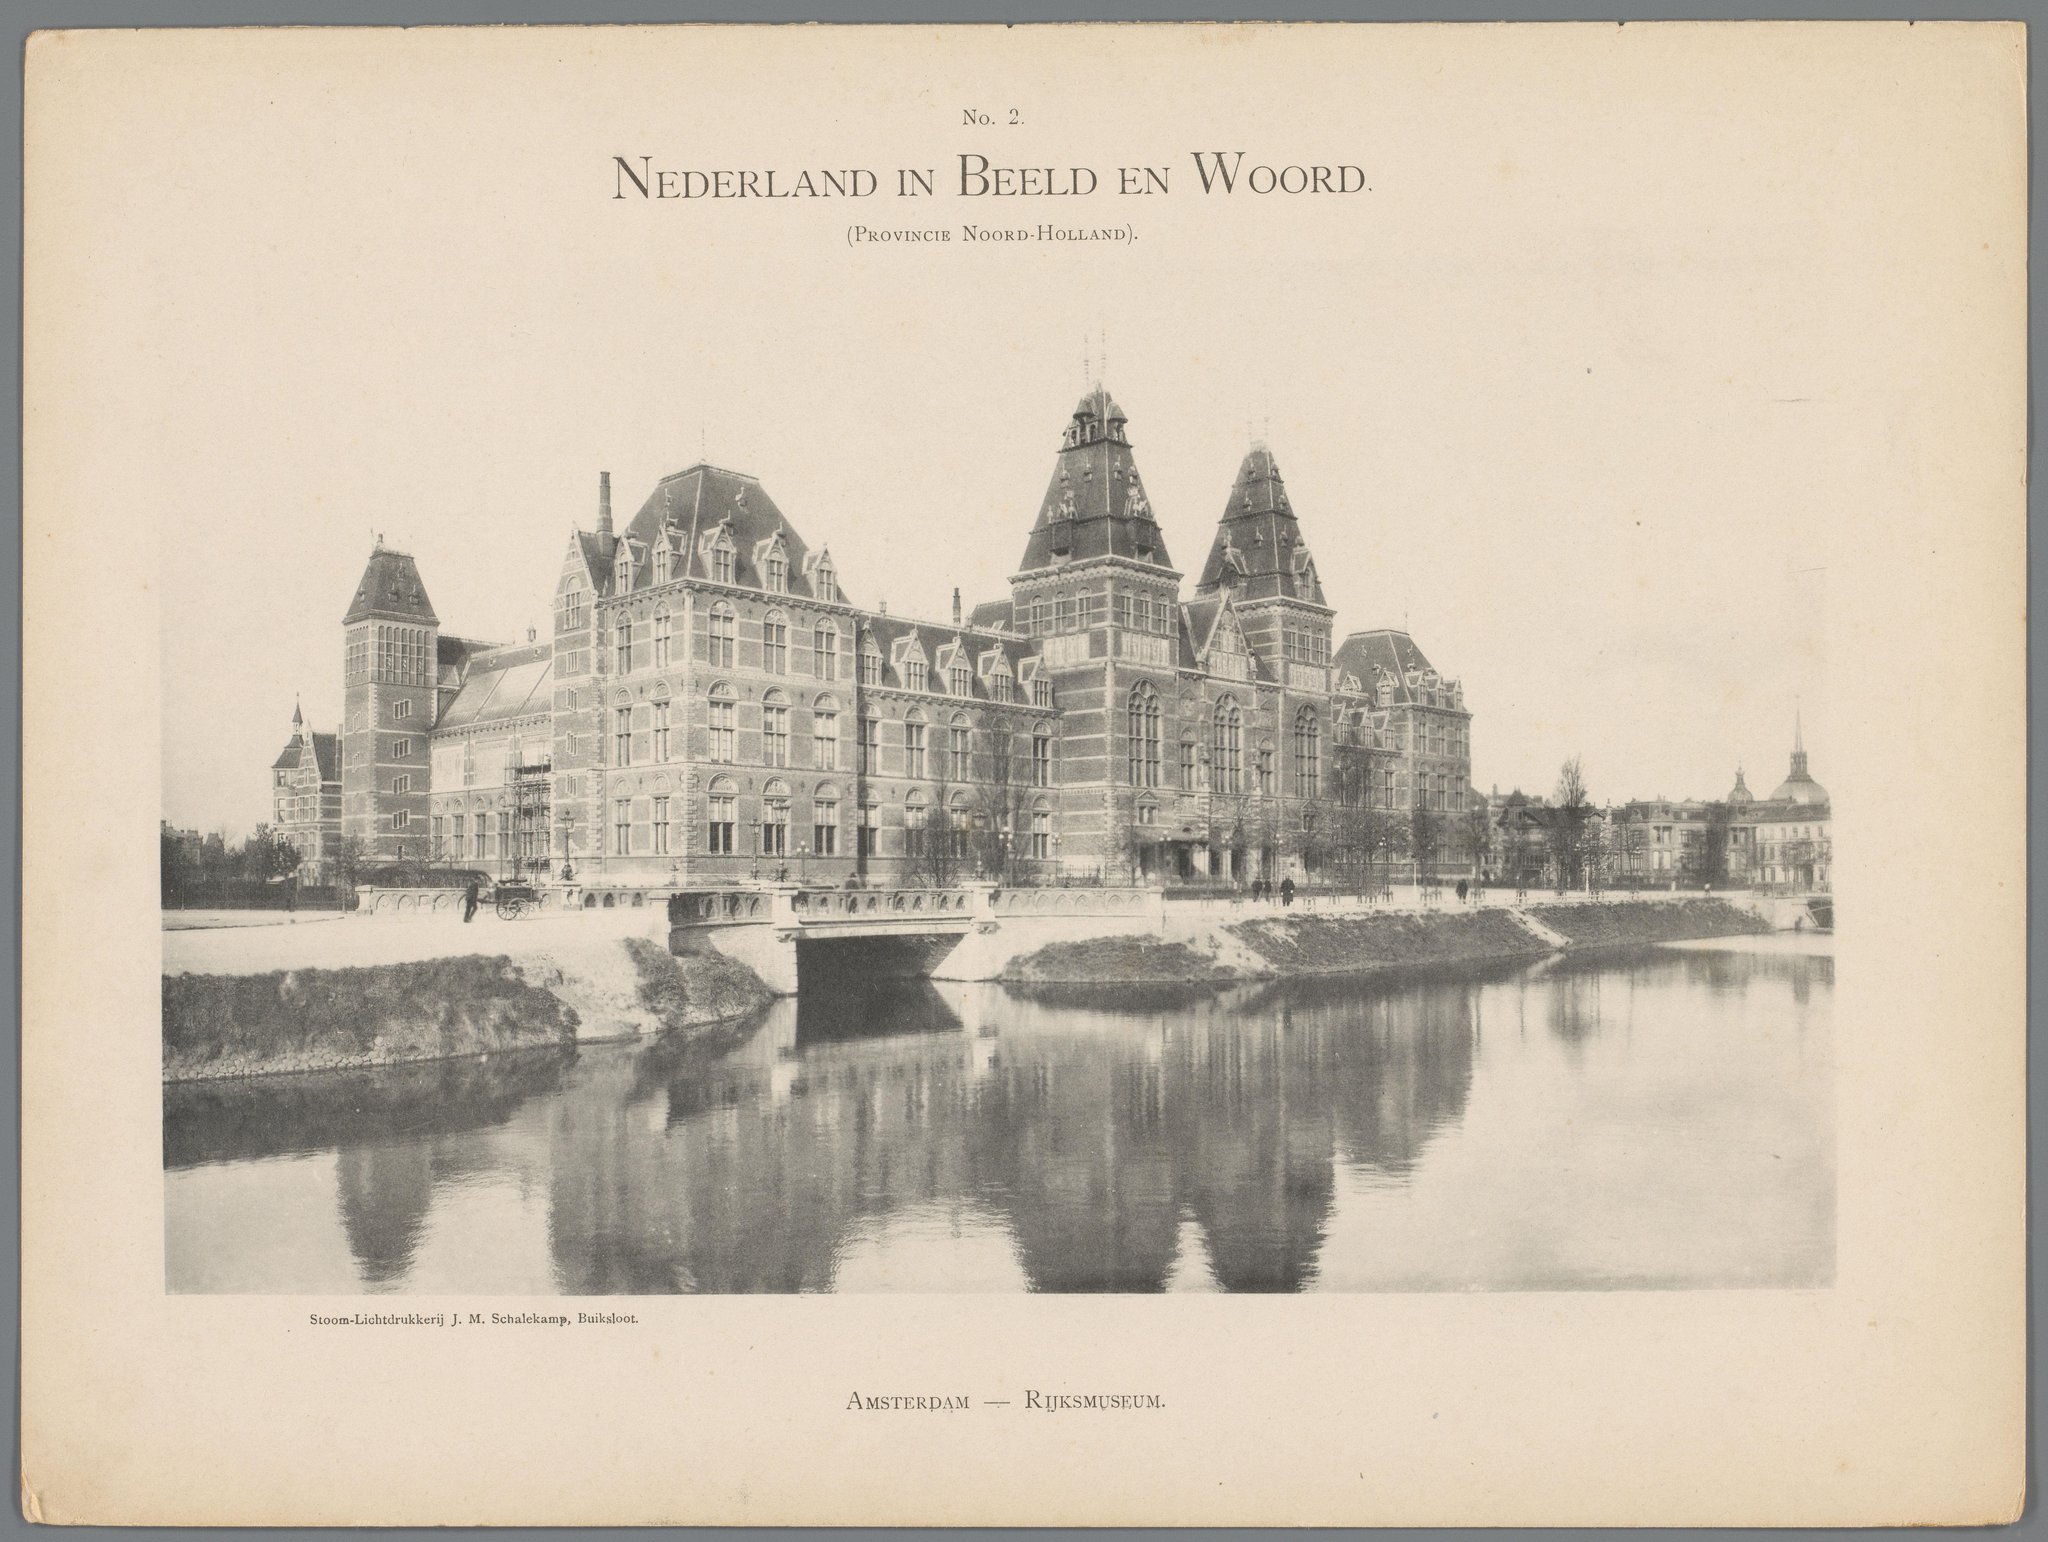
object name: photomechanical print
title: Amsterdam - Rijksmuseum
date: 1890-1895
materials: cardboard, paper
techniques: photograph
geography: buiksloot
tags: permanent exhibition, museum, exterior ~ representation of a building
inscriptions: number: ‘No. 2.’